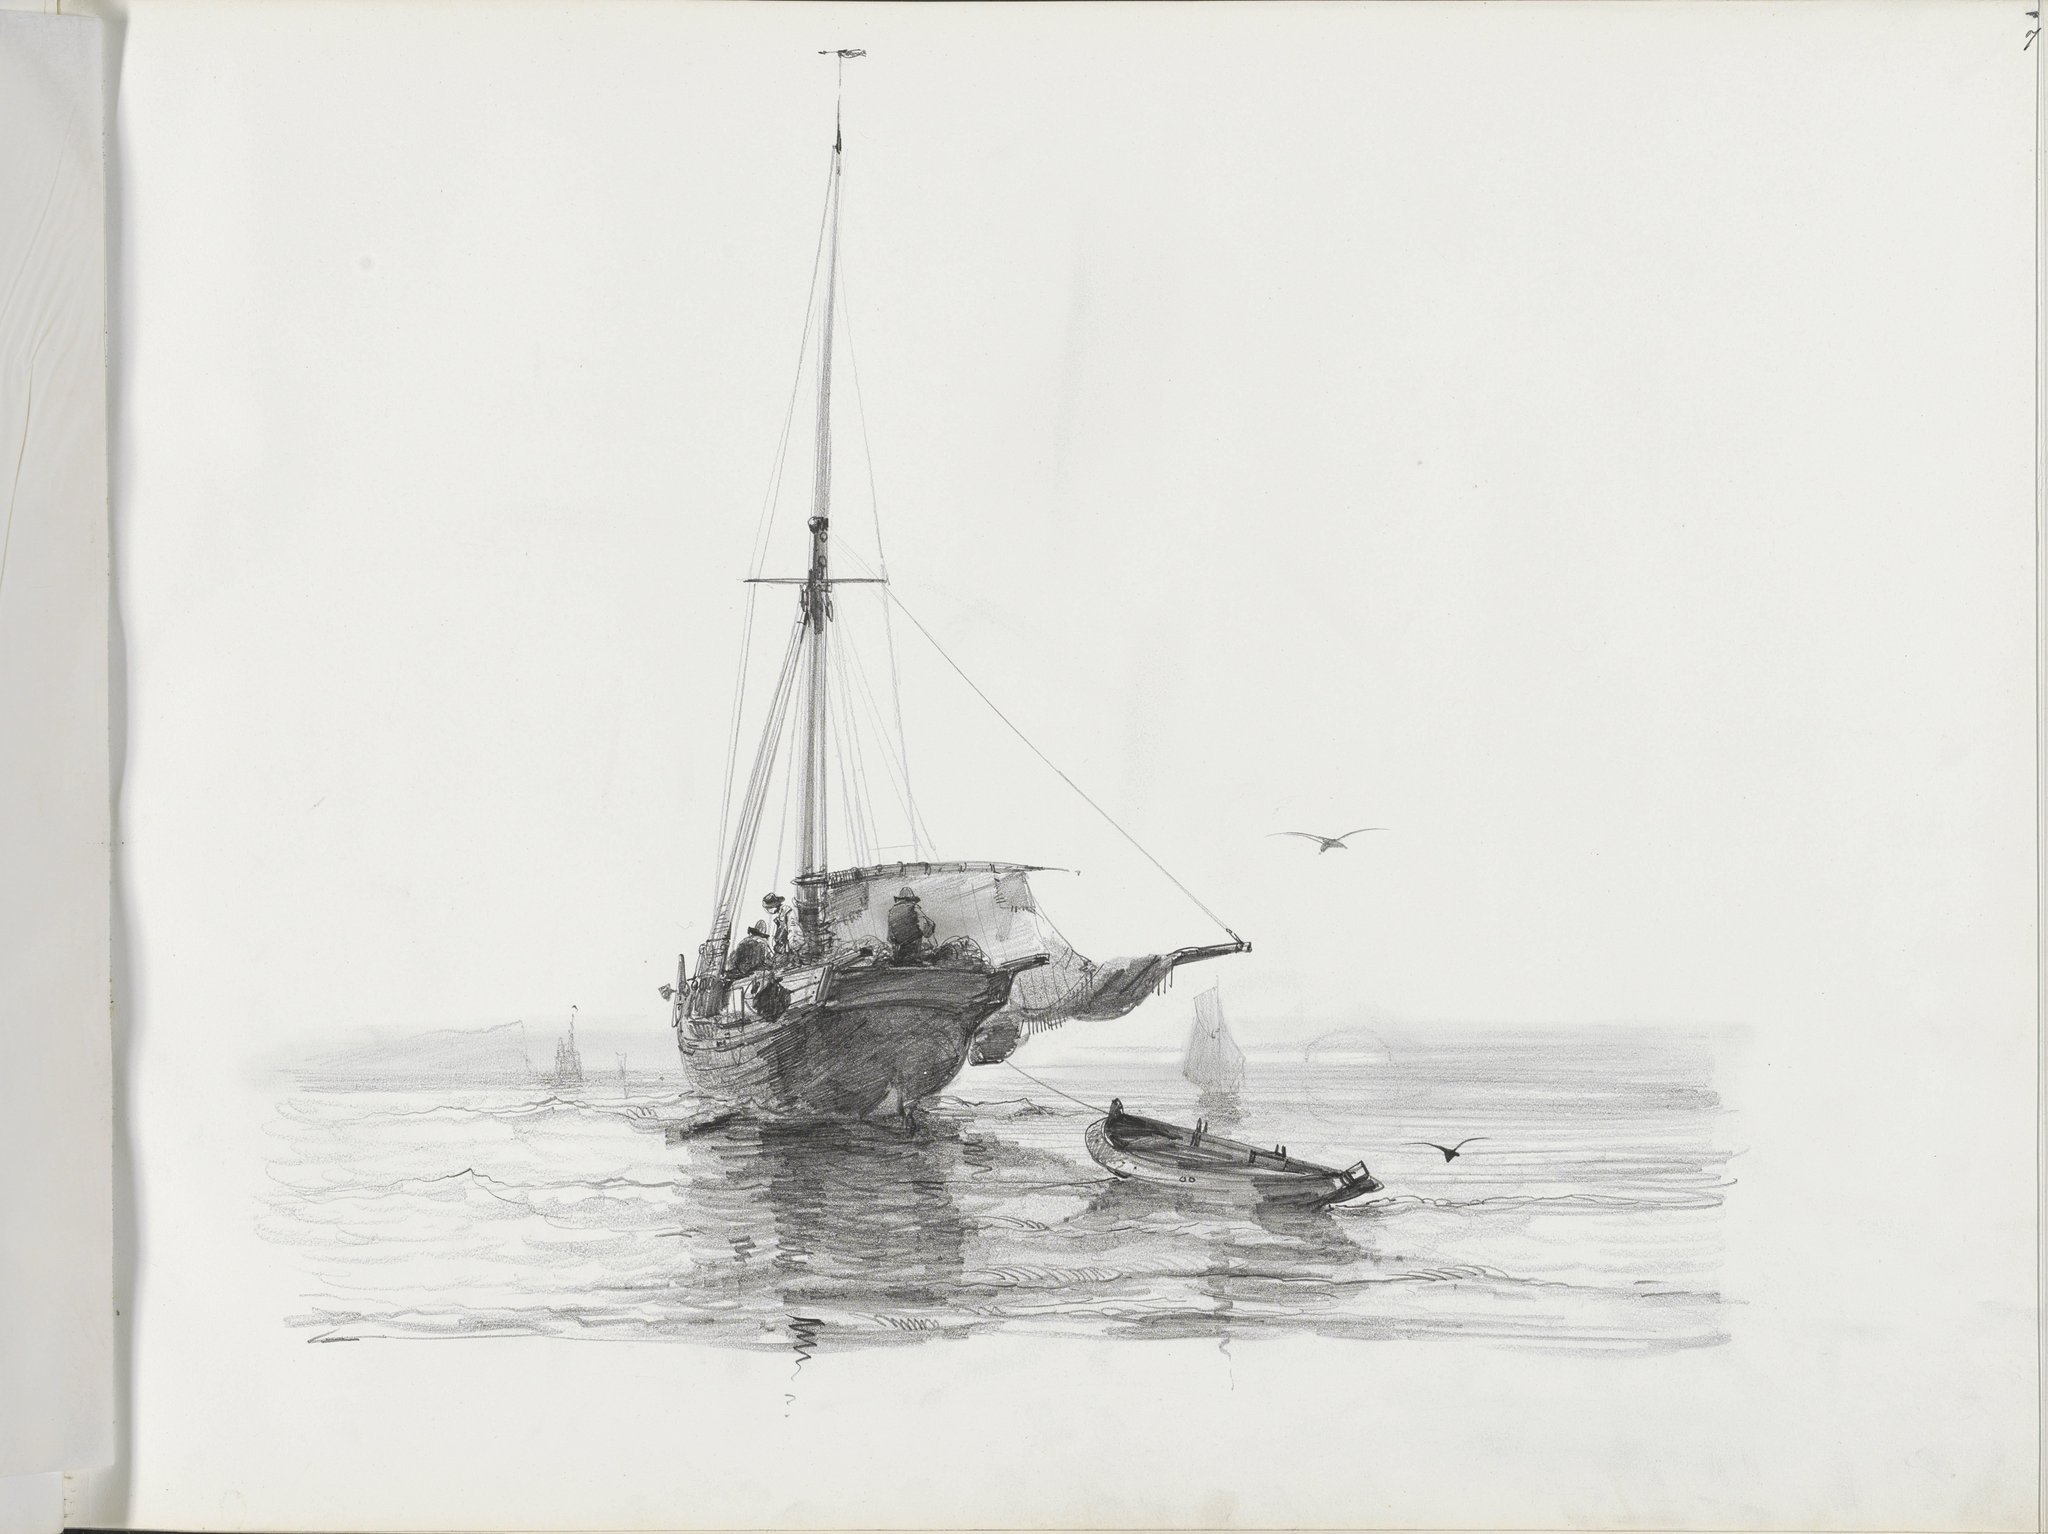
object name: sketchbook leaf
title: Afgemeerd zeilschip op een kalme zee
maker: albertus van beest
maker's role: draughtsman, print maker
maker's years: 1820-1860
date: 1830-1860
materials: paper, pencil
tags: sailing-ship, sailing-boat, landscapes with waters, waterscapes, seascapes (in the temperate zone)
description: Blad 7 recto uit een schetsboek met 46 bladen.